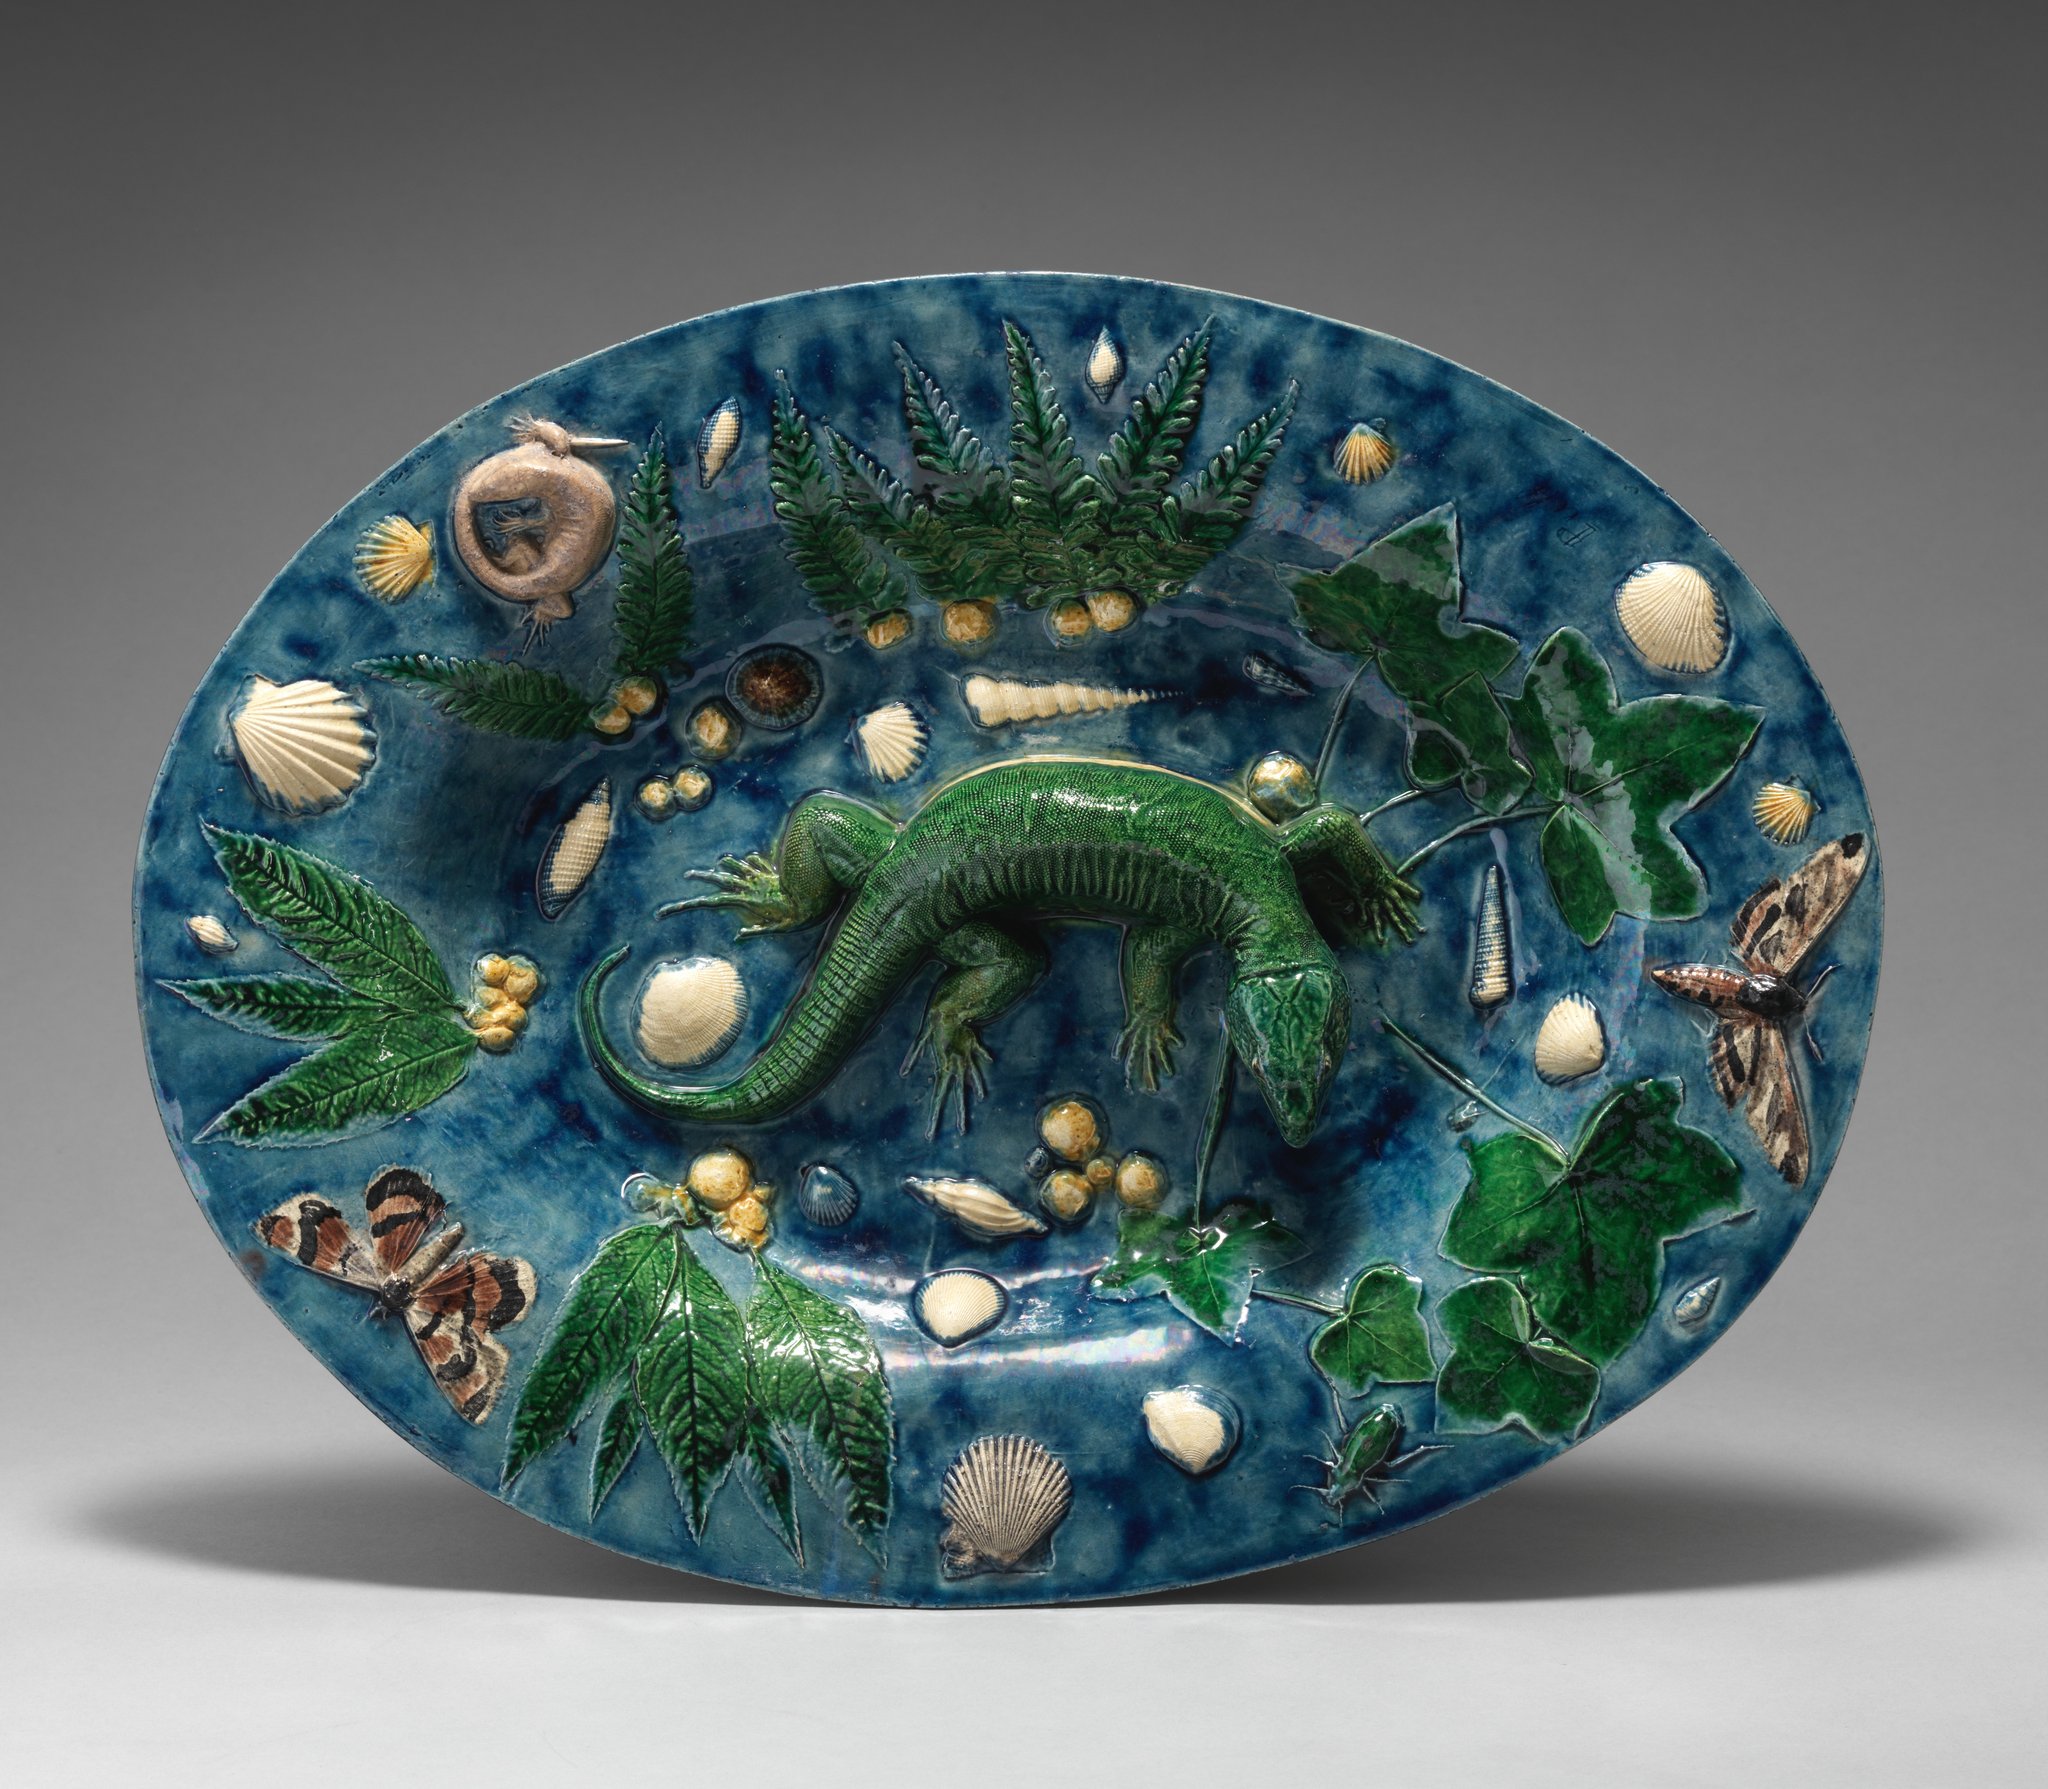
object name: basin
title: Oval basin with lizard, shells, and light blue background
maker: georges pull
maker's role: maker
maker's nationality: french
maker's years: 1810-1889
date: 1865-1875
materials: earthenware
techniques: glazing